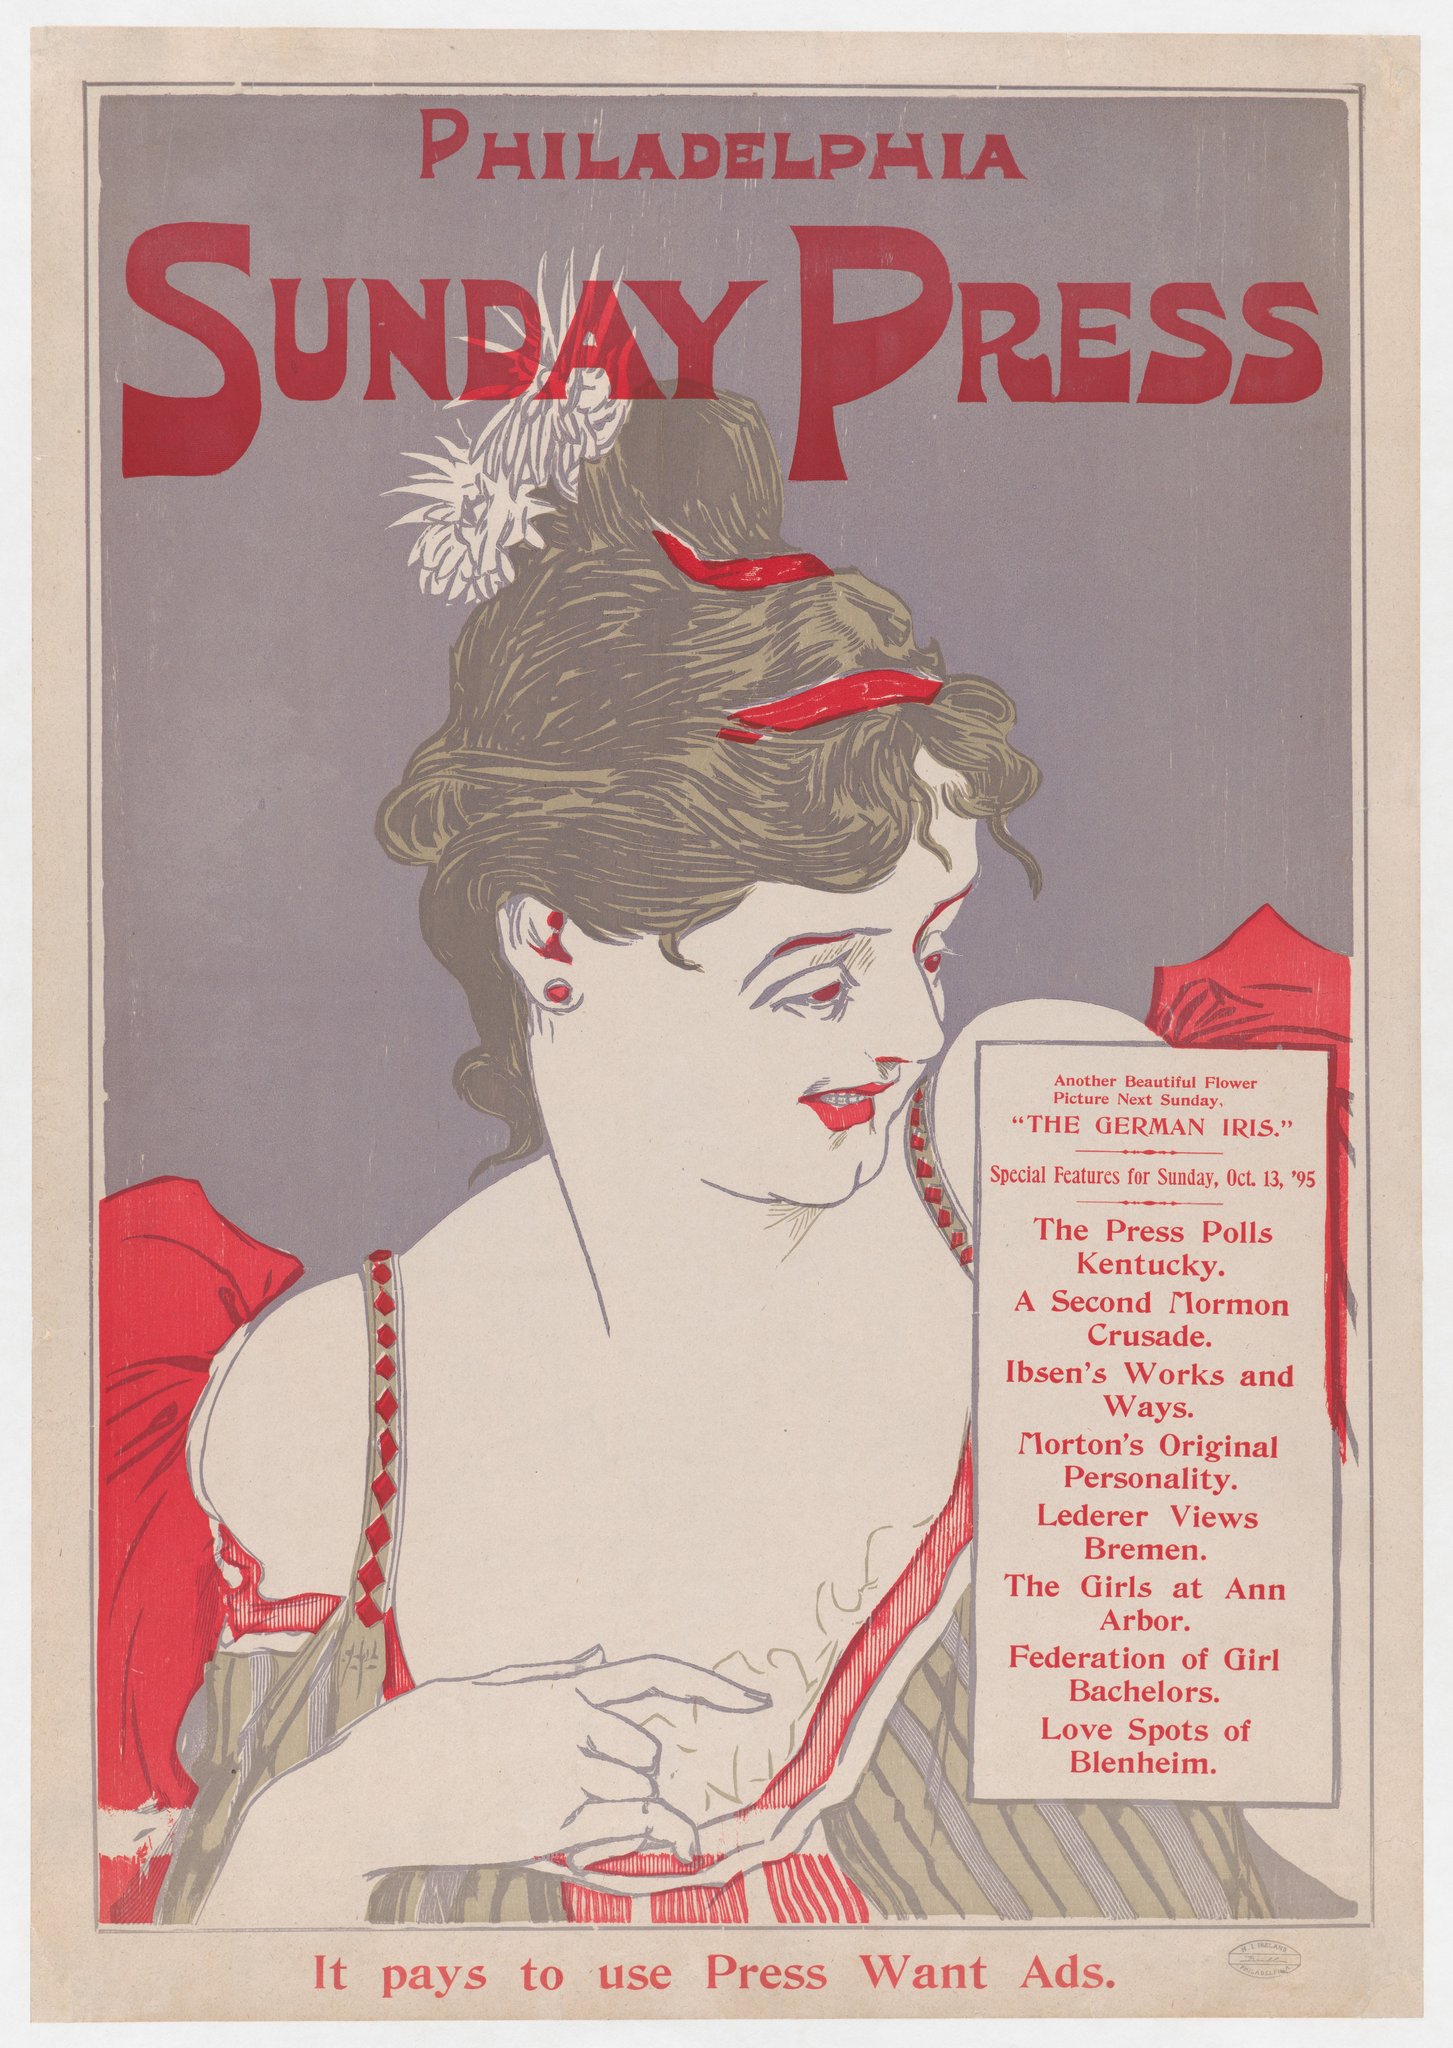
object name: poster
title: Advertisement for Philadelphia Sunday Press, Oct. 13, 1895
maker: george reiter brill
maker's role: artist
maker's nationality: american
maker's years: 1867-1918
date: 1895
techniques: lithograph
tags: women,advertisements